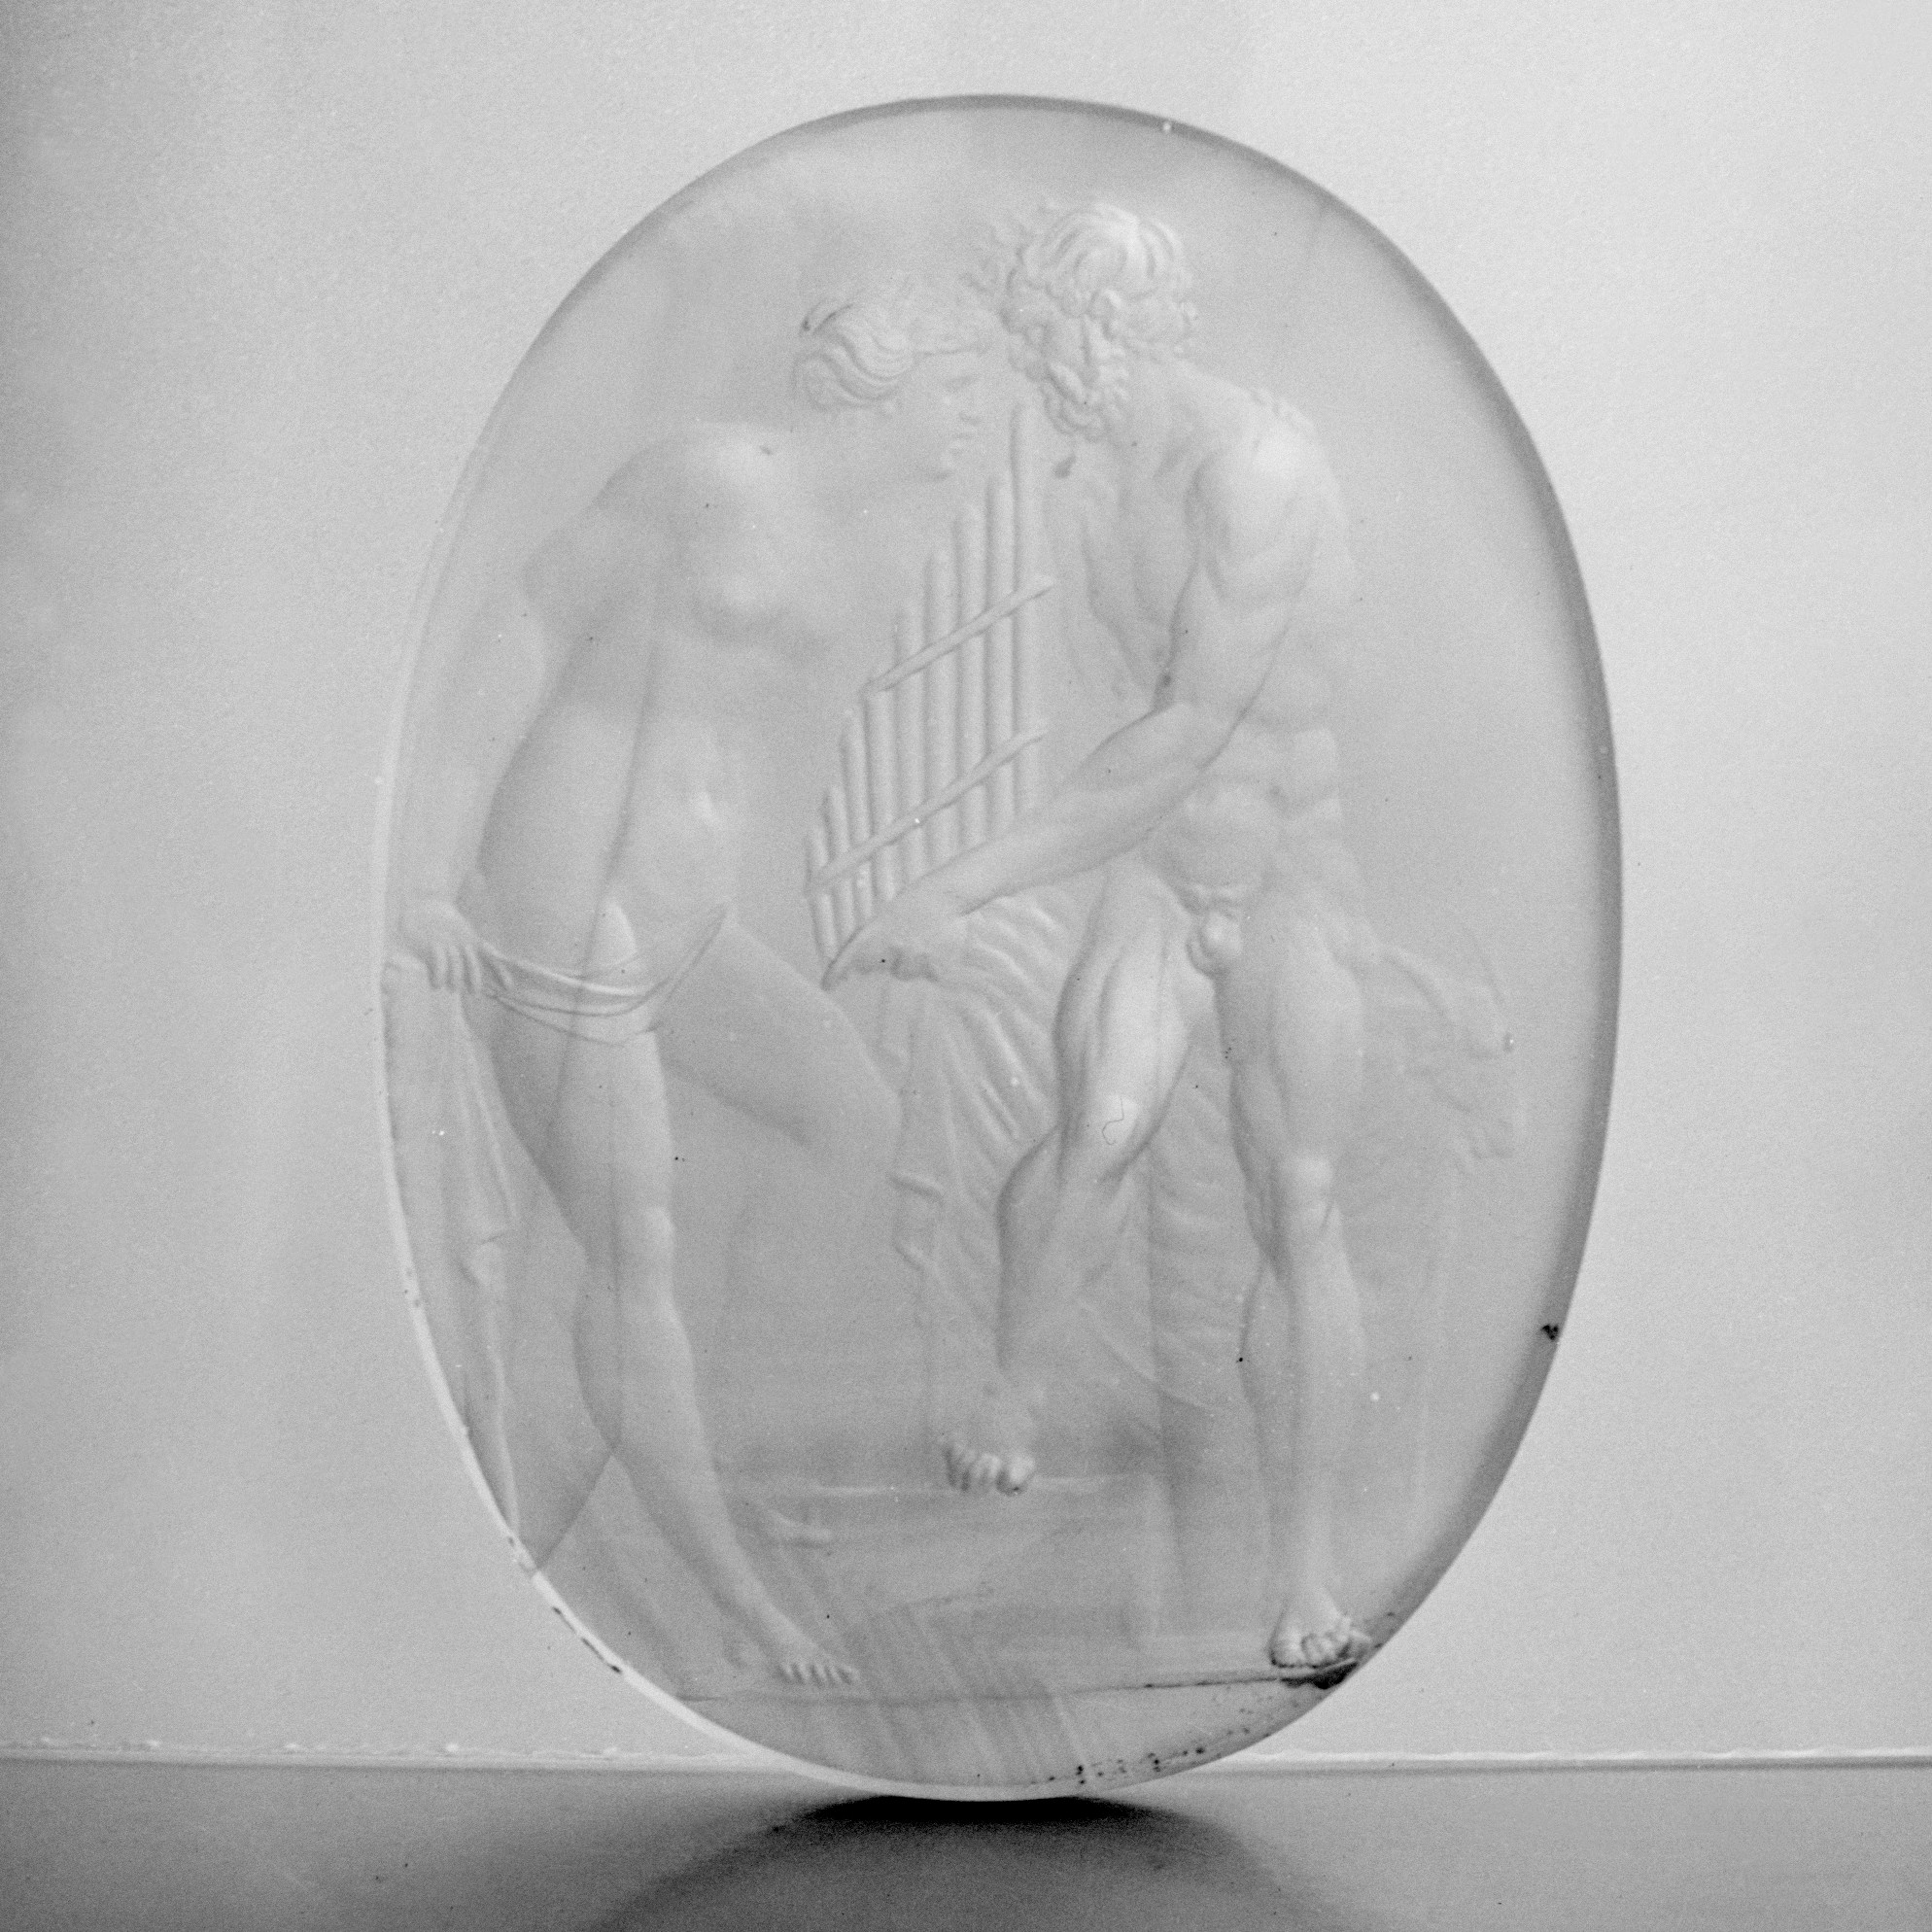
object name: intaglio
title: Pan and nymph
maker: valerio belli (il vicentino)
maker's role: maker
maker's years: 1468-1546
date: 1501-1533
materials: stone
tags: male nudes,nymphs